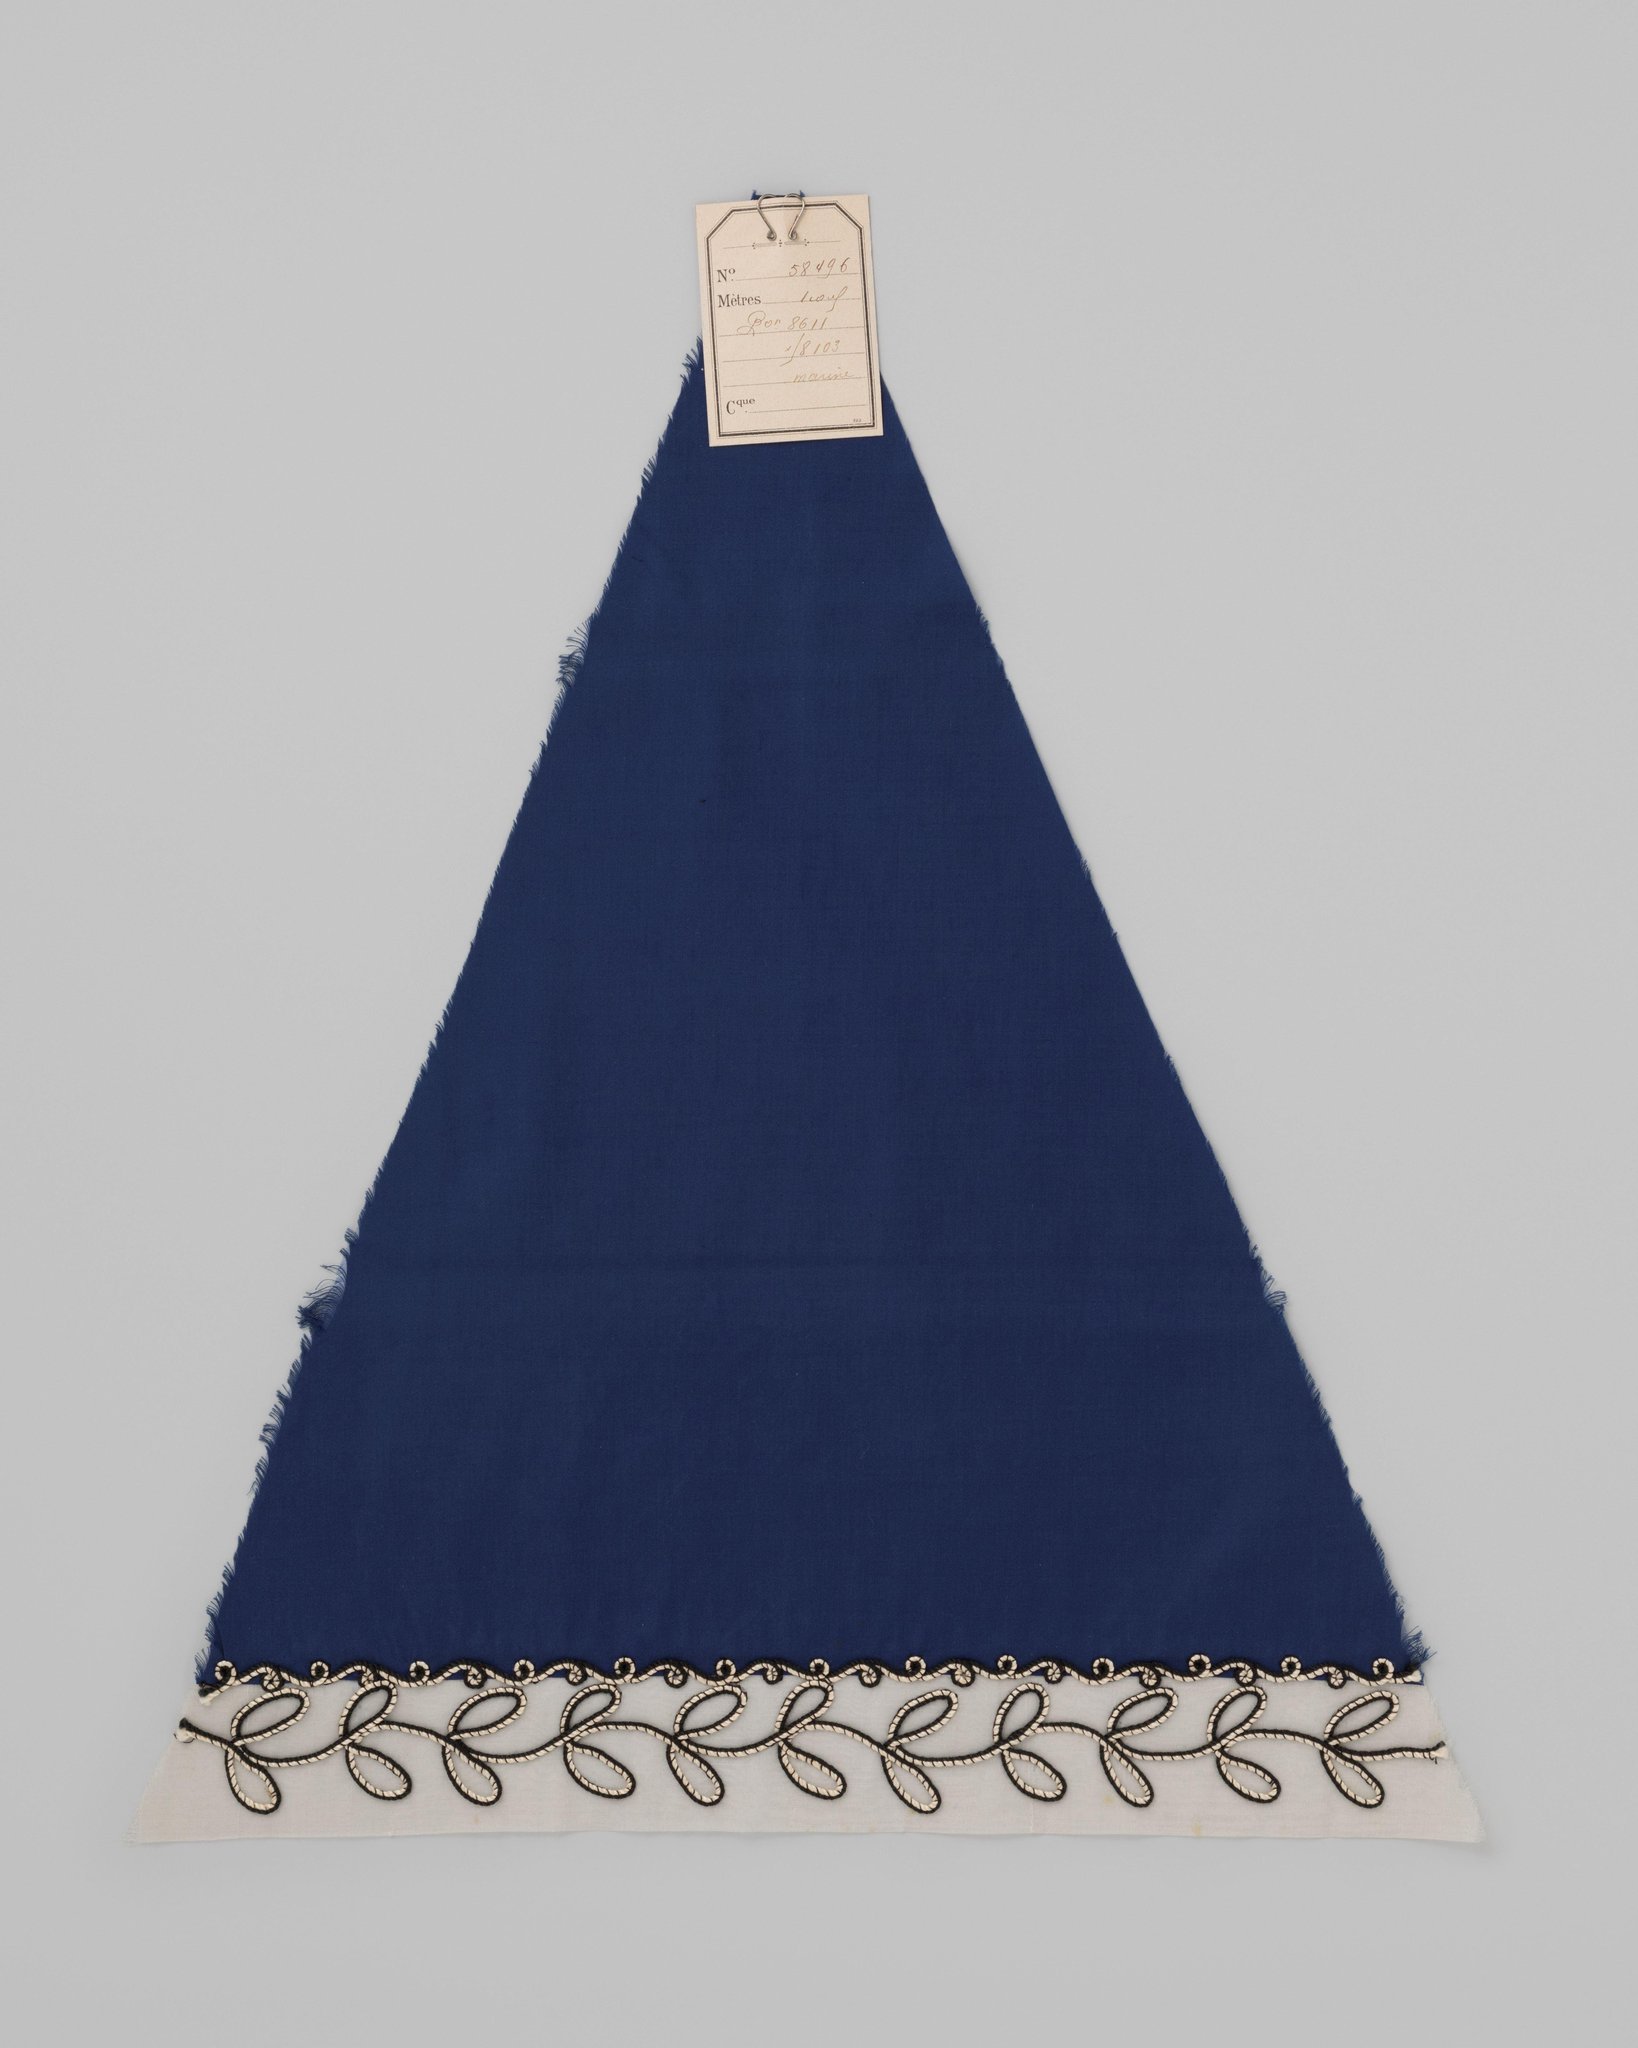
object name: parasoldek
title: Sector van een parasoldek van donkerblauw katoen, met een met woldraad geborduurde rand van batist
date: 1885-1900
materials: cotton, wool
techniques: embroidered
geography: nijmegen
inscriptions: label: ‘No 58496 // Mètres 1 coup // Pon 8611 // 8103 // marine’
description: Sector van een parasoldek van donkerblauw katoen, met een met woldraad geborduurde rand van batist. Aan de stof is een etiket bevestigd met een metalen klem.